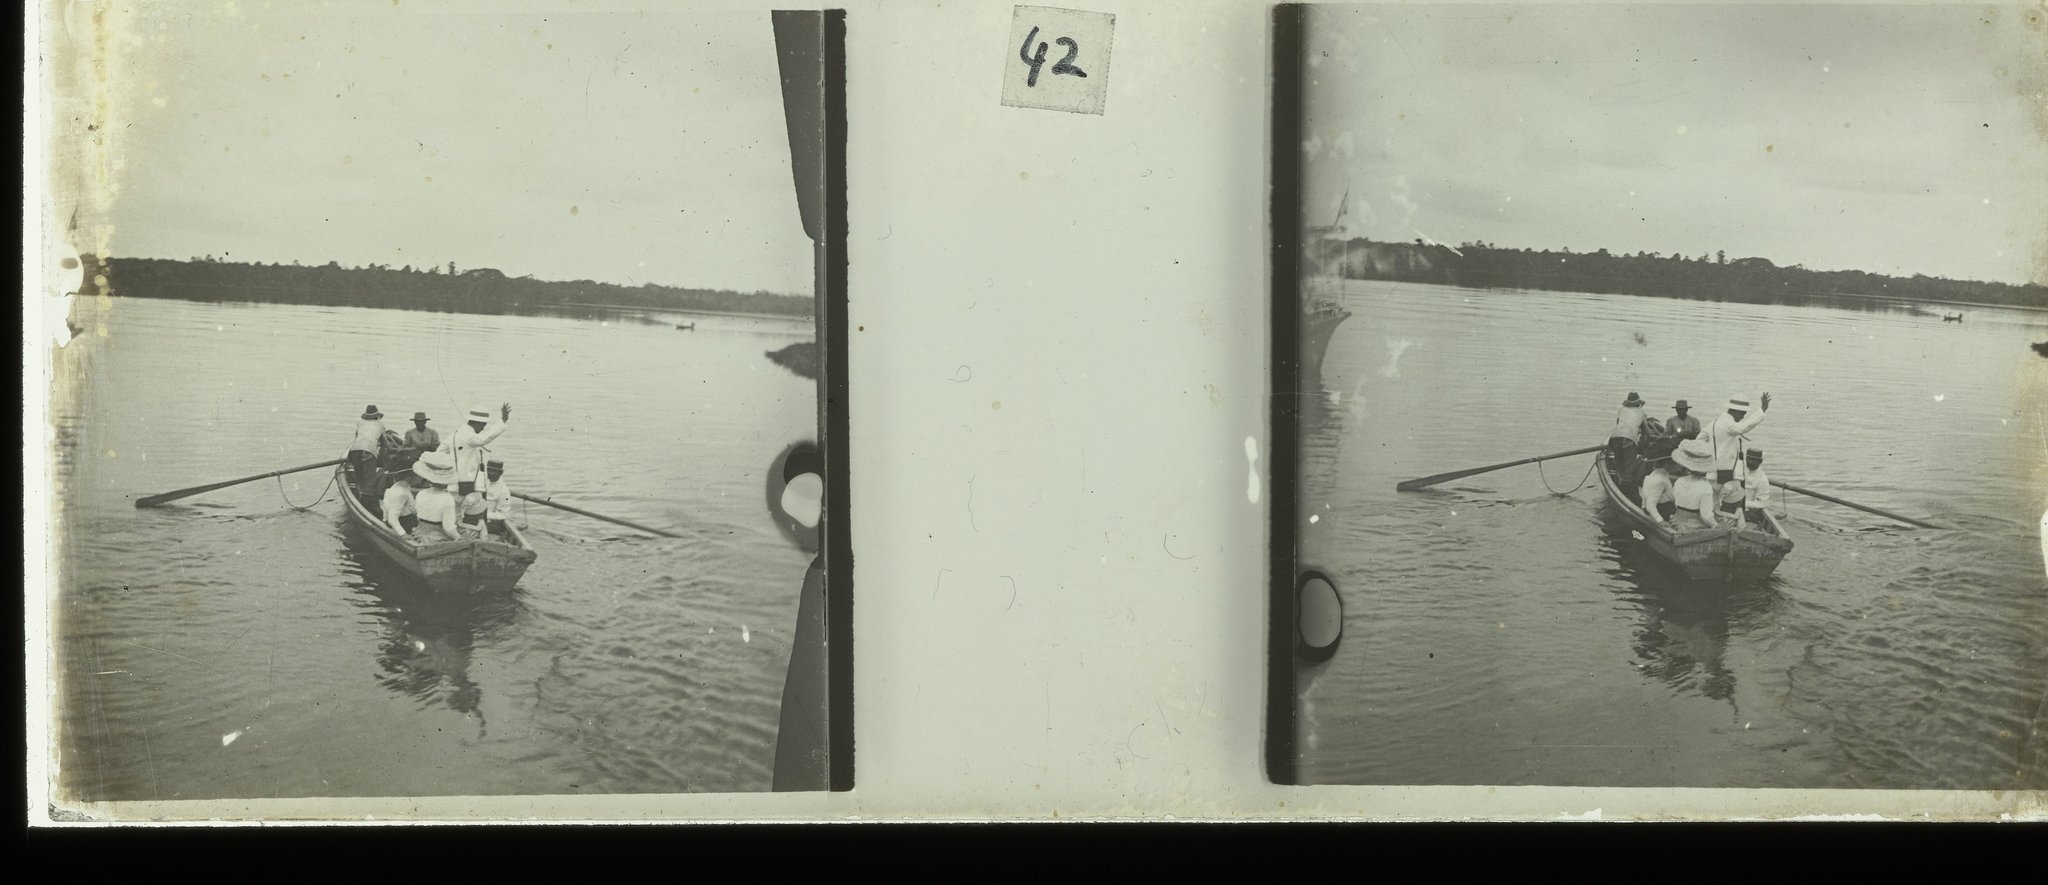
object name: stereograph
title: Visite gaat weg van plantage Accaribo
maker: theodoor brouwers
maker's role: amateurfotograaf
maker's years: 1874-1932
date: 1913-1930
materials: glass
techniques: photography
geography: suriname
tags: amsterdam, theodoor brouwers, plantation, suriname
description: In de periode 1911-1932 woonde op plantage Accaribo in Suriname de familie Brouwers van wie de foto's afkomstig zijn. Rond 1910 vond Theodoor Brouwers werk op plantage Accaribo. In 1929 werd hij eigenaar van de plantage. Op Accaribo werden in zijn tijd bananen geproduceerd en wat koffie.